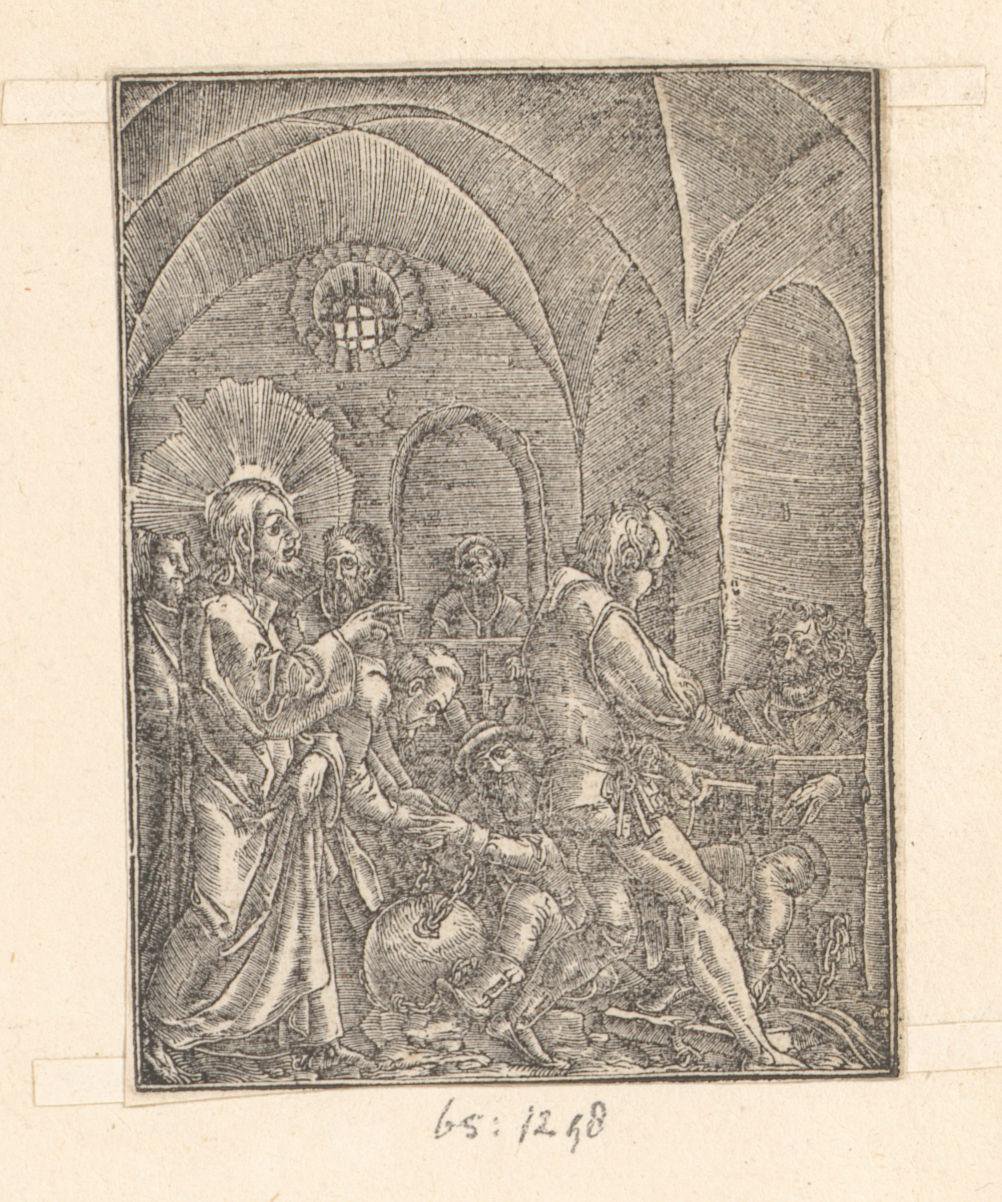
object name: album leaf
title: Christus bevrijdt gevangenen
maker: monogrammist cv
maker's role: print maker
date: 1523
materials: paper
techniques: metal cut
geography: germany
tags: visiting or liberating the imprisoned, 'incarceratus solatur' ~ one of the (seven) acts of mercy - vv - christ present, 'and forgive us our debts, as we also have forgiven our debtors' ~ the lord's prayer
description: Christus verschijnt en laat gevangenen uit de gevangenis bevrijden. Illustratie bij een zin uit het Onze Vader: Vergeef ons onze schulden, zoals ook wij hebben vergeven wie ons iets schuldig was. Prent maakt deel uit van een album.